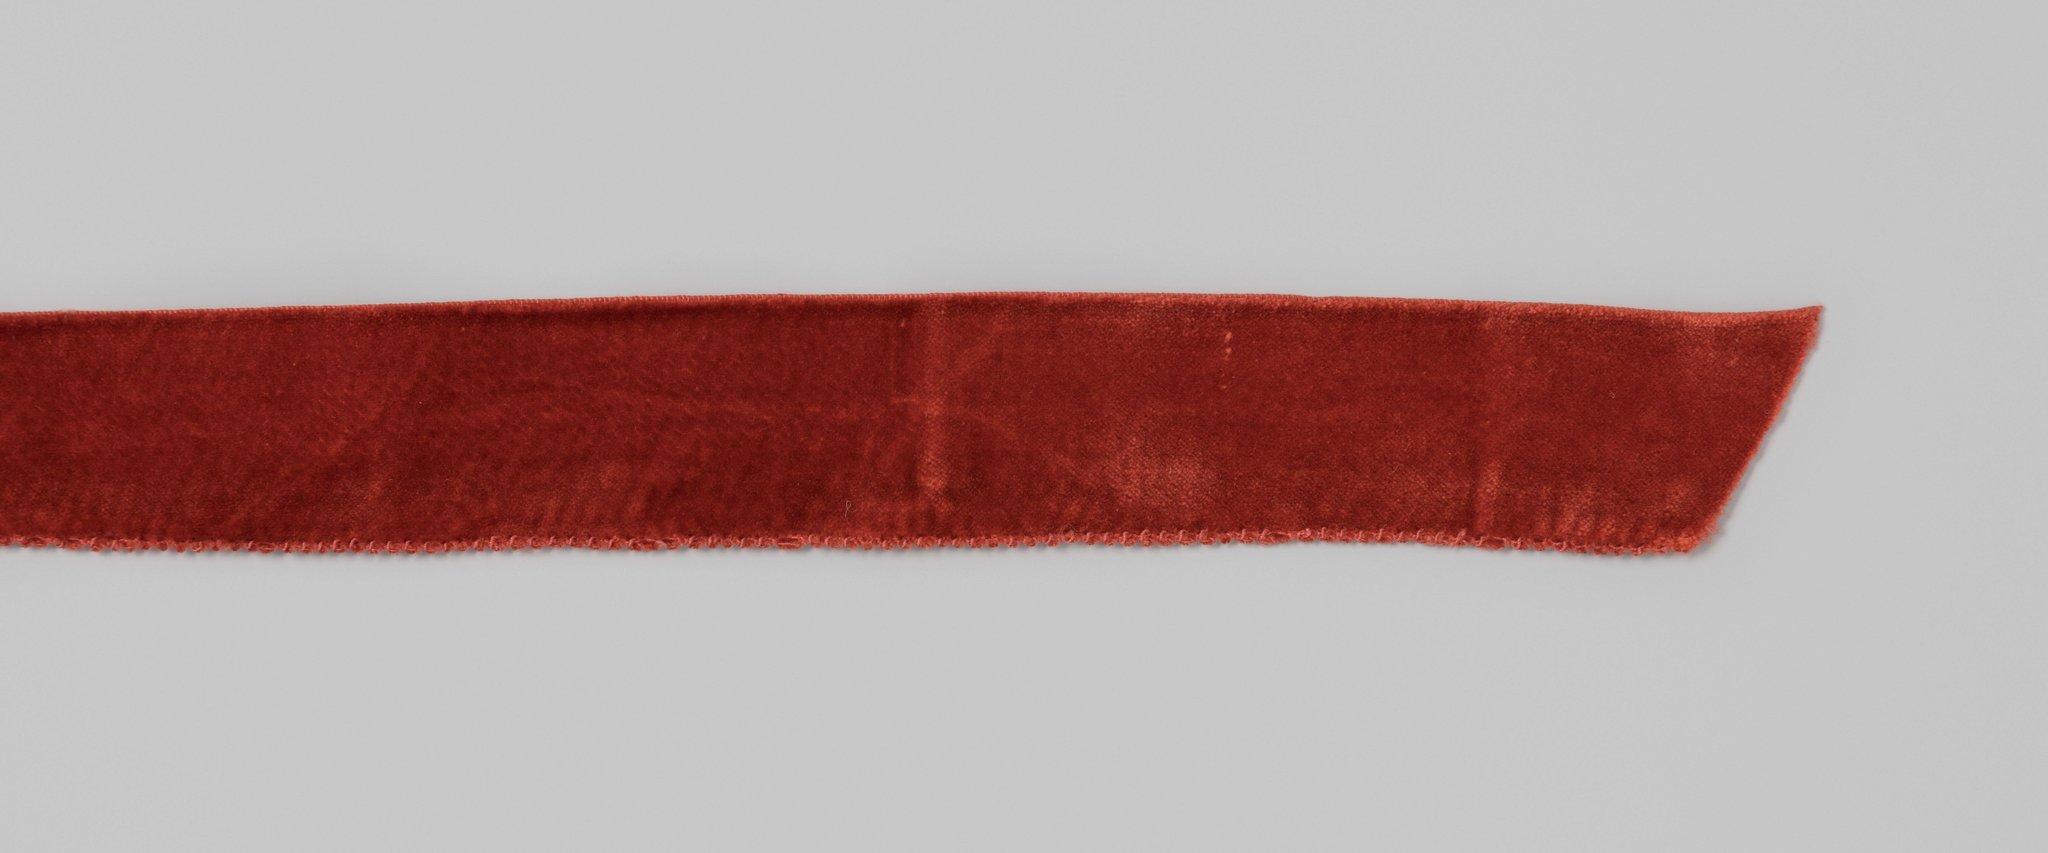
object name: ribbon material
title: Lint van rood fluweel, bestaande uit drie aan elkaar genaaide stukken lint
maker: Anonymous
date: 1400-1950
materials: velvet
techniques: weave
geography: western europe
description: Lint van rood fluweel, bestaande uit drie aan elkaar genaaide stukken lint.